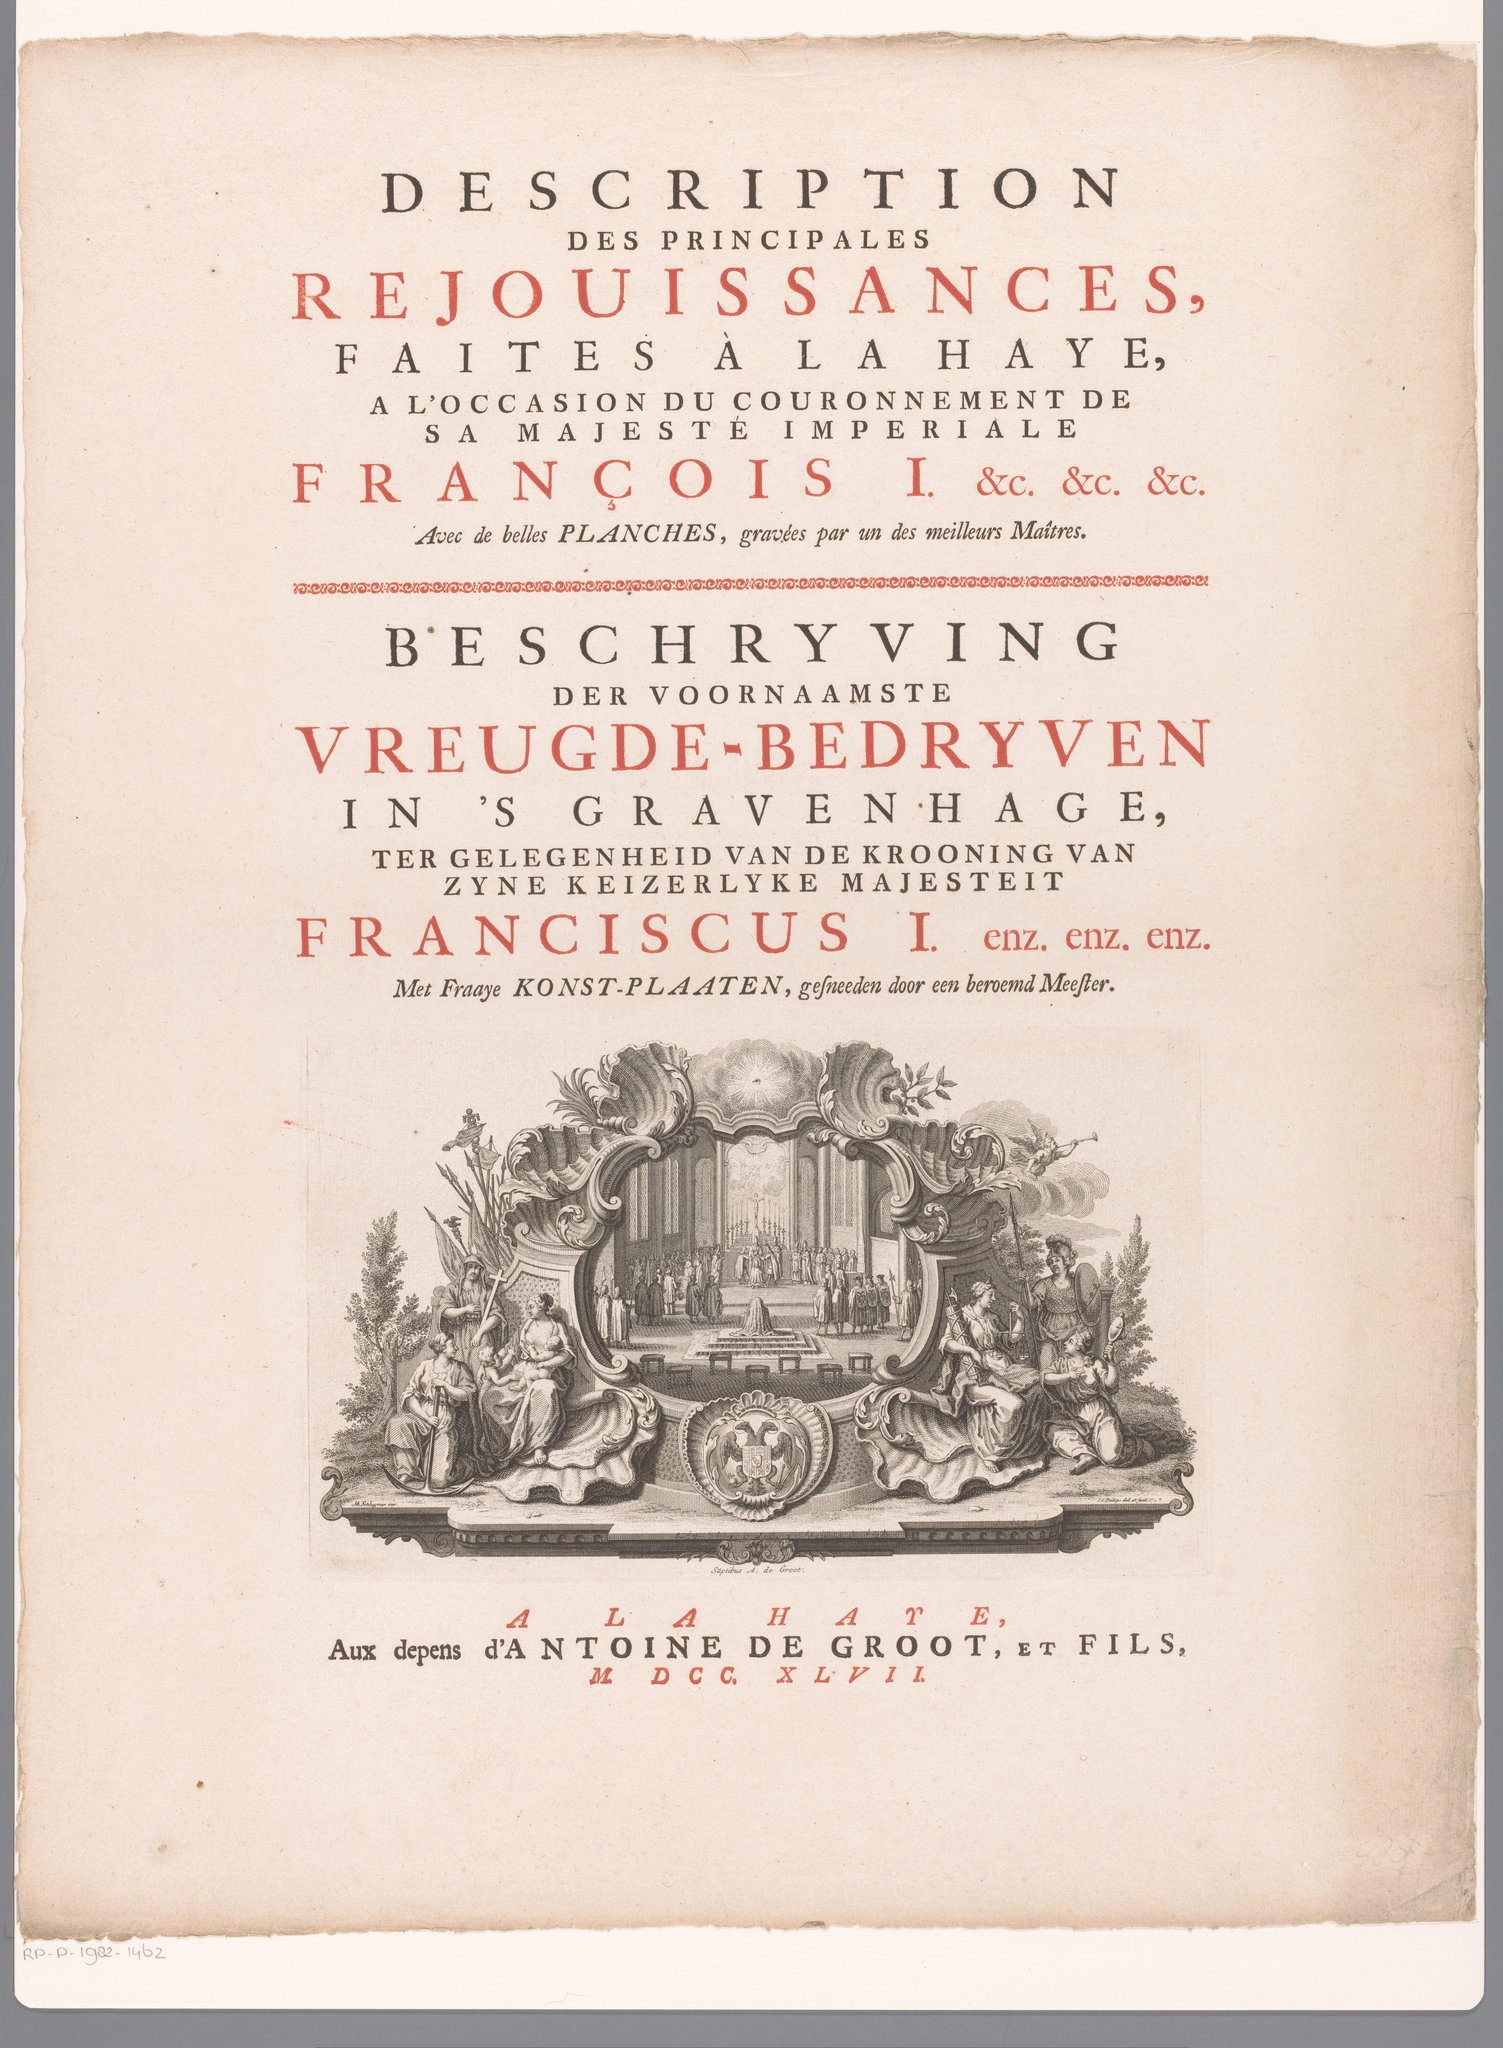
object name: print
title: Description des principales rejouissances, faites à la Haye, a l'occasion du couronnnement de (...) François I / Beschryving der voornaamste vreugde-bedryven in 's Gravenhage ter gelegenheid van de krooning van zyne keizerlyke majesteit Franciscus I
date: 1747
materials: paper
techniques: engraving, etching, letterpress printing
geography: the hague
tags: frans i stefan (duits keizer), 'sapientia' and the seven virtues, i.e. the three theological and the four cardinal virtues, during the coronation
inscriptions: collector's mark: Lugt 2228, collector's mark: Lugt 2760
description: Titelprent van een plaatwerk over de kroning van Frans I Stefan tot keizer op 4-6 oktober 1745. Blad met de titels in het Frans en Nederlands en een groot vignet met de kroning in een kerk. In het randwerk de allegorische figuren van Geloof, Hoop en Liefde en Wijsheid, Rechtvaardigheid en Voorzichtigheid, het keizerlijke wapen en rocailles.